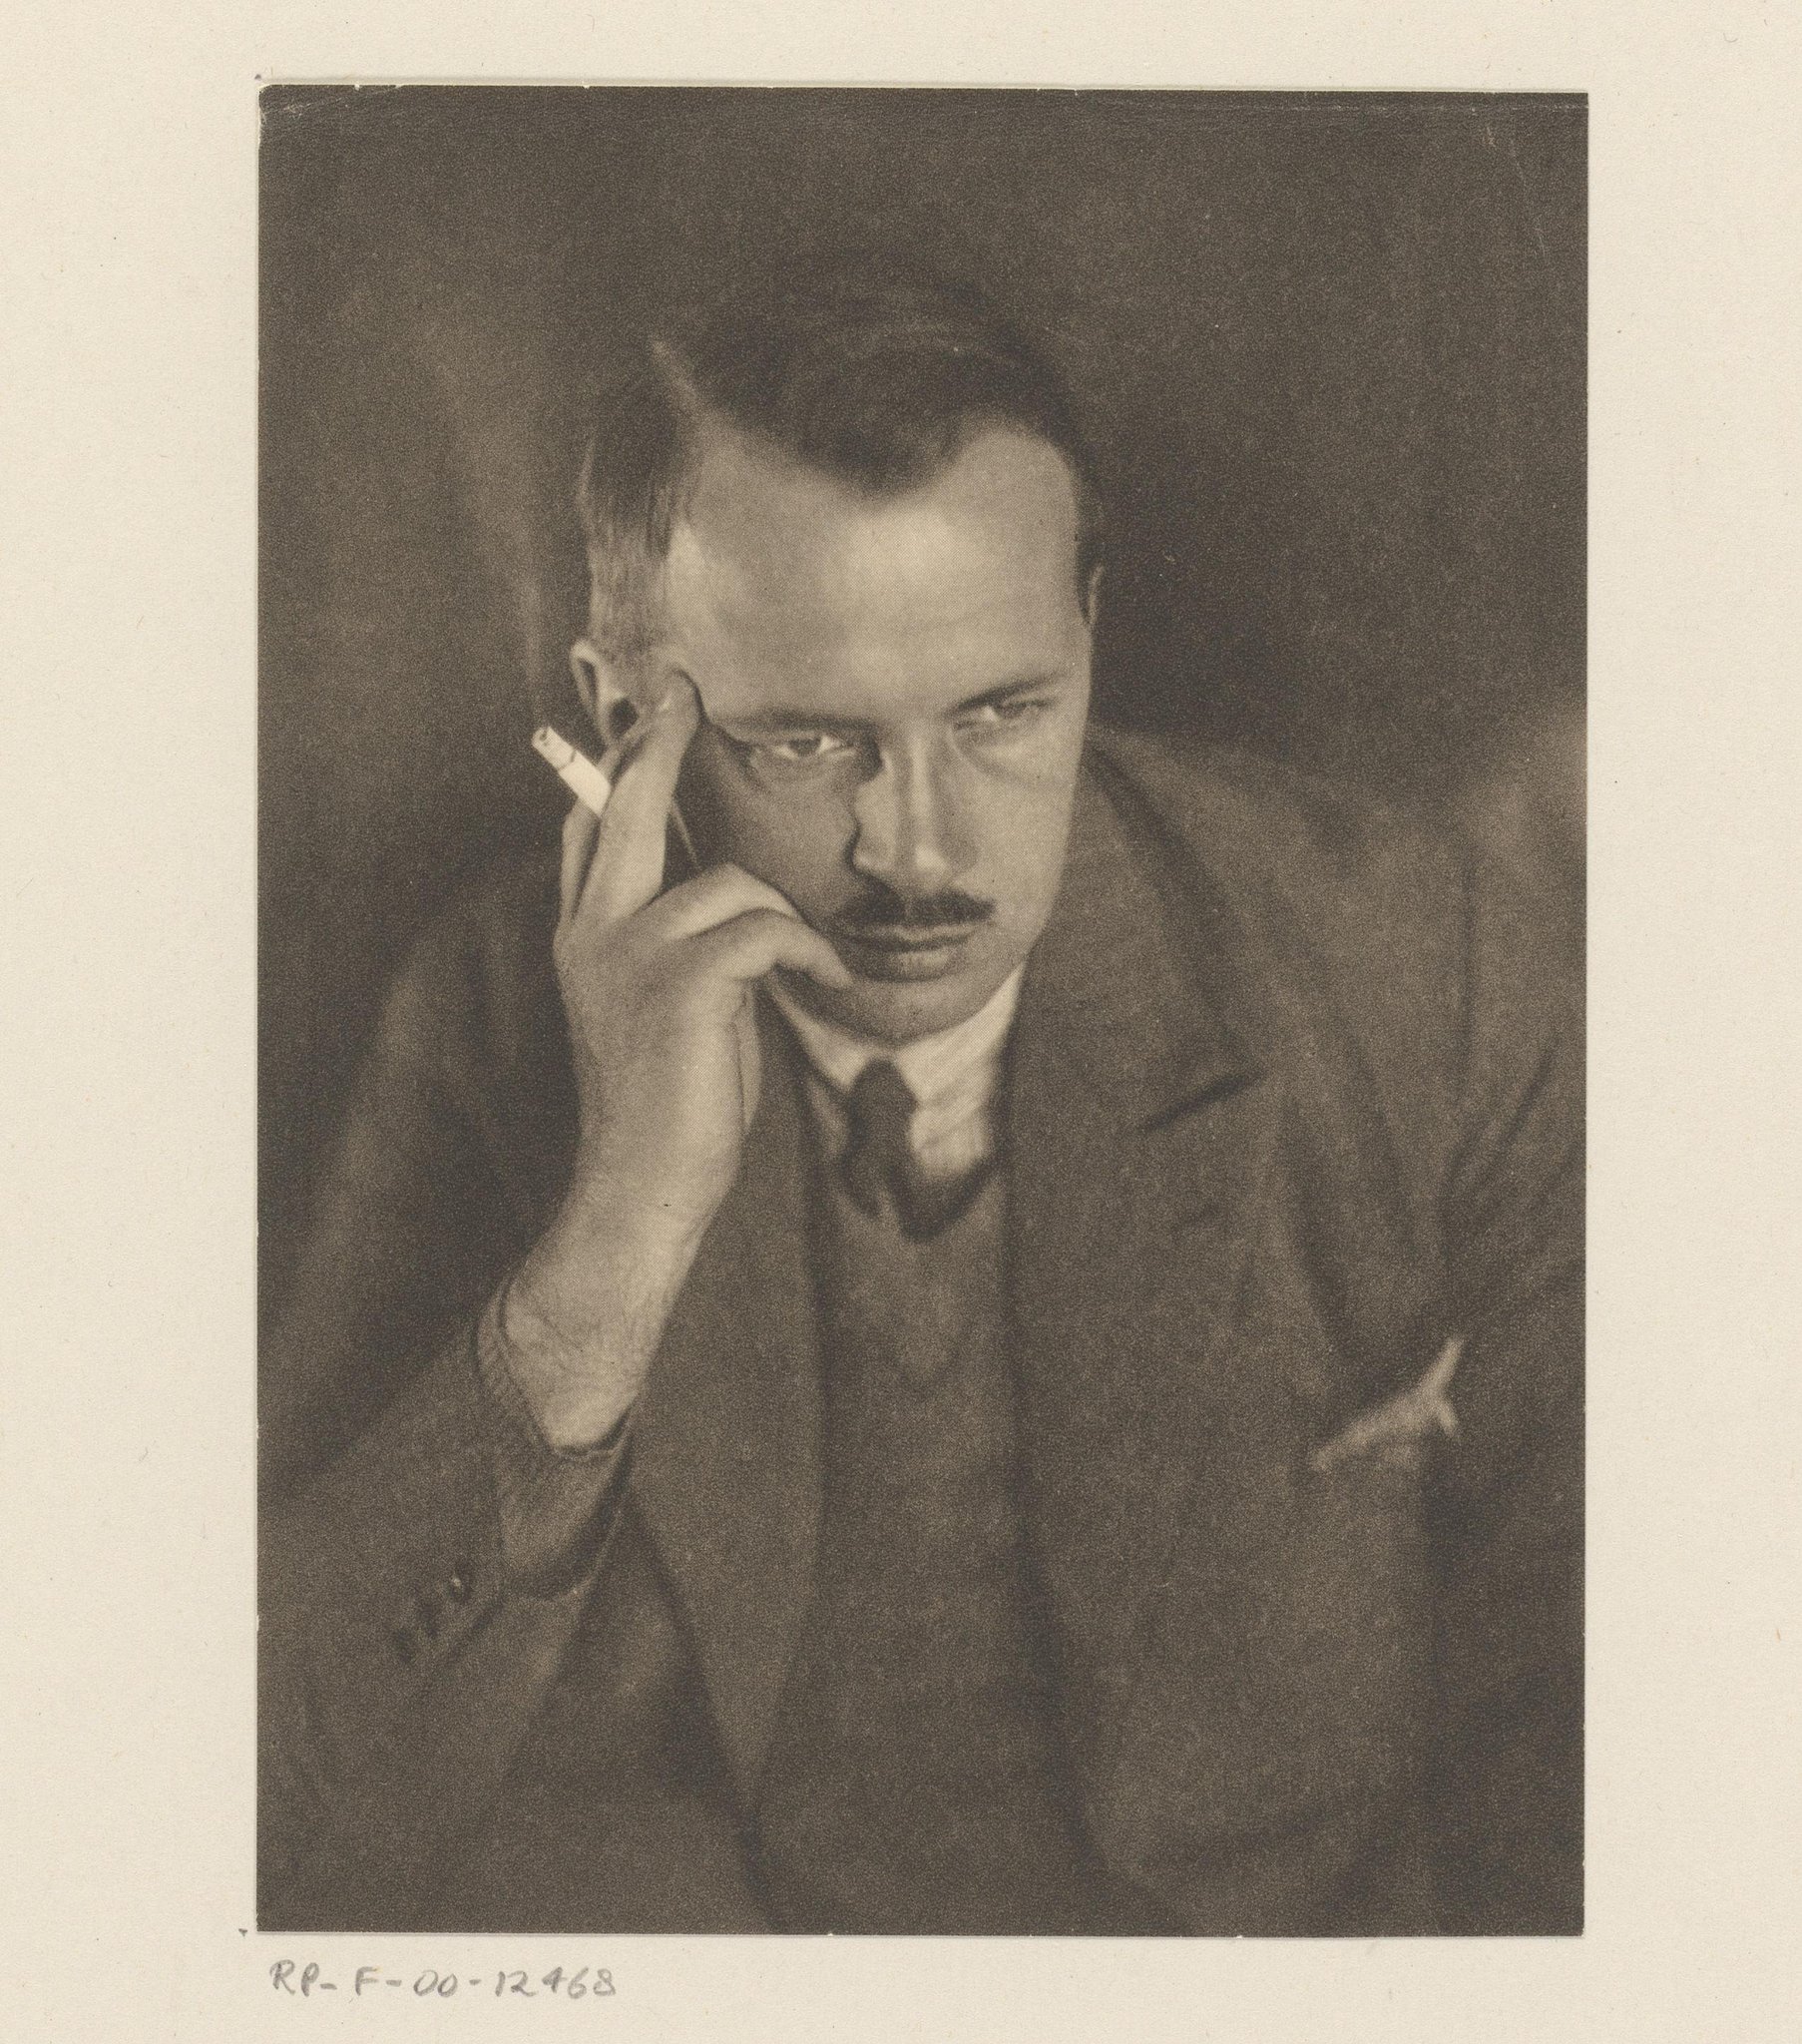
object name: photomechanical print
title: Portret van Johan Fabricius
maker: Anonymous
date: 1925-1940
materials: paper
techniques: rotogravure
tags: print maker, johan fabricius, cigarette, historical persons, writer, poet, author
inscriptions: inscription: ‘Johan Fabricius/ geb. 1899’